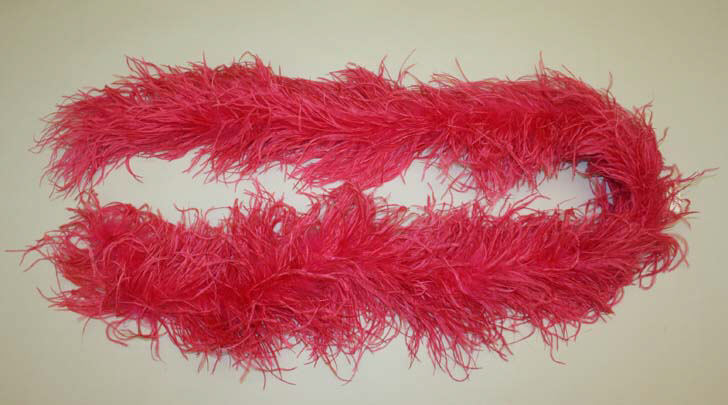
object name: boa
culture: american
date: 1890-1899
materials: feather